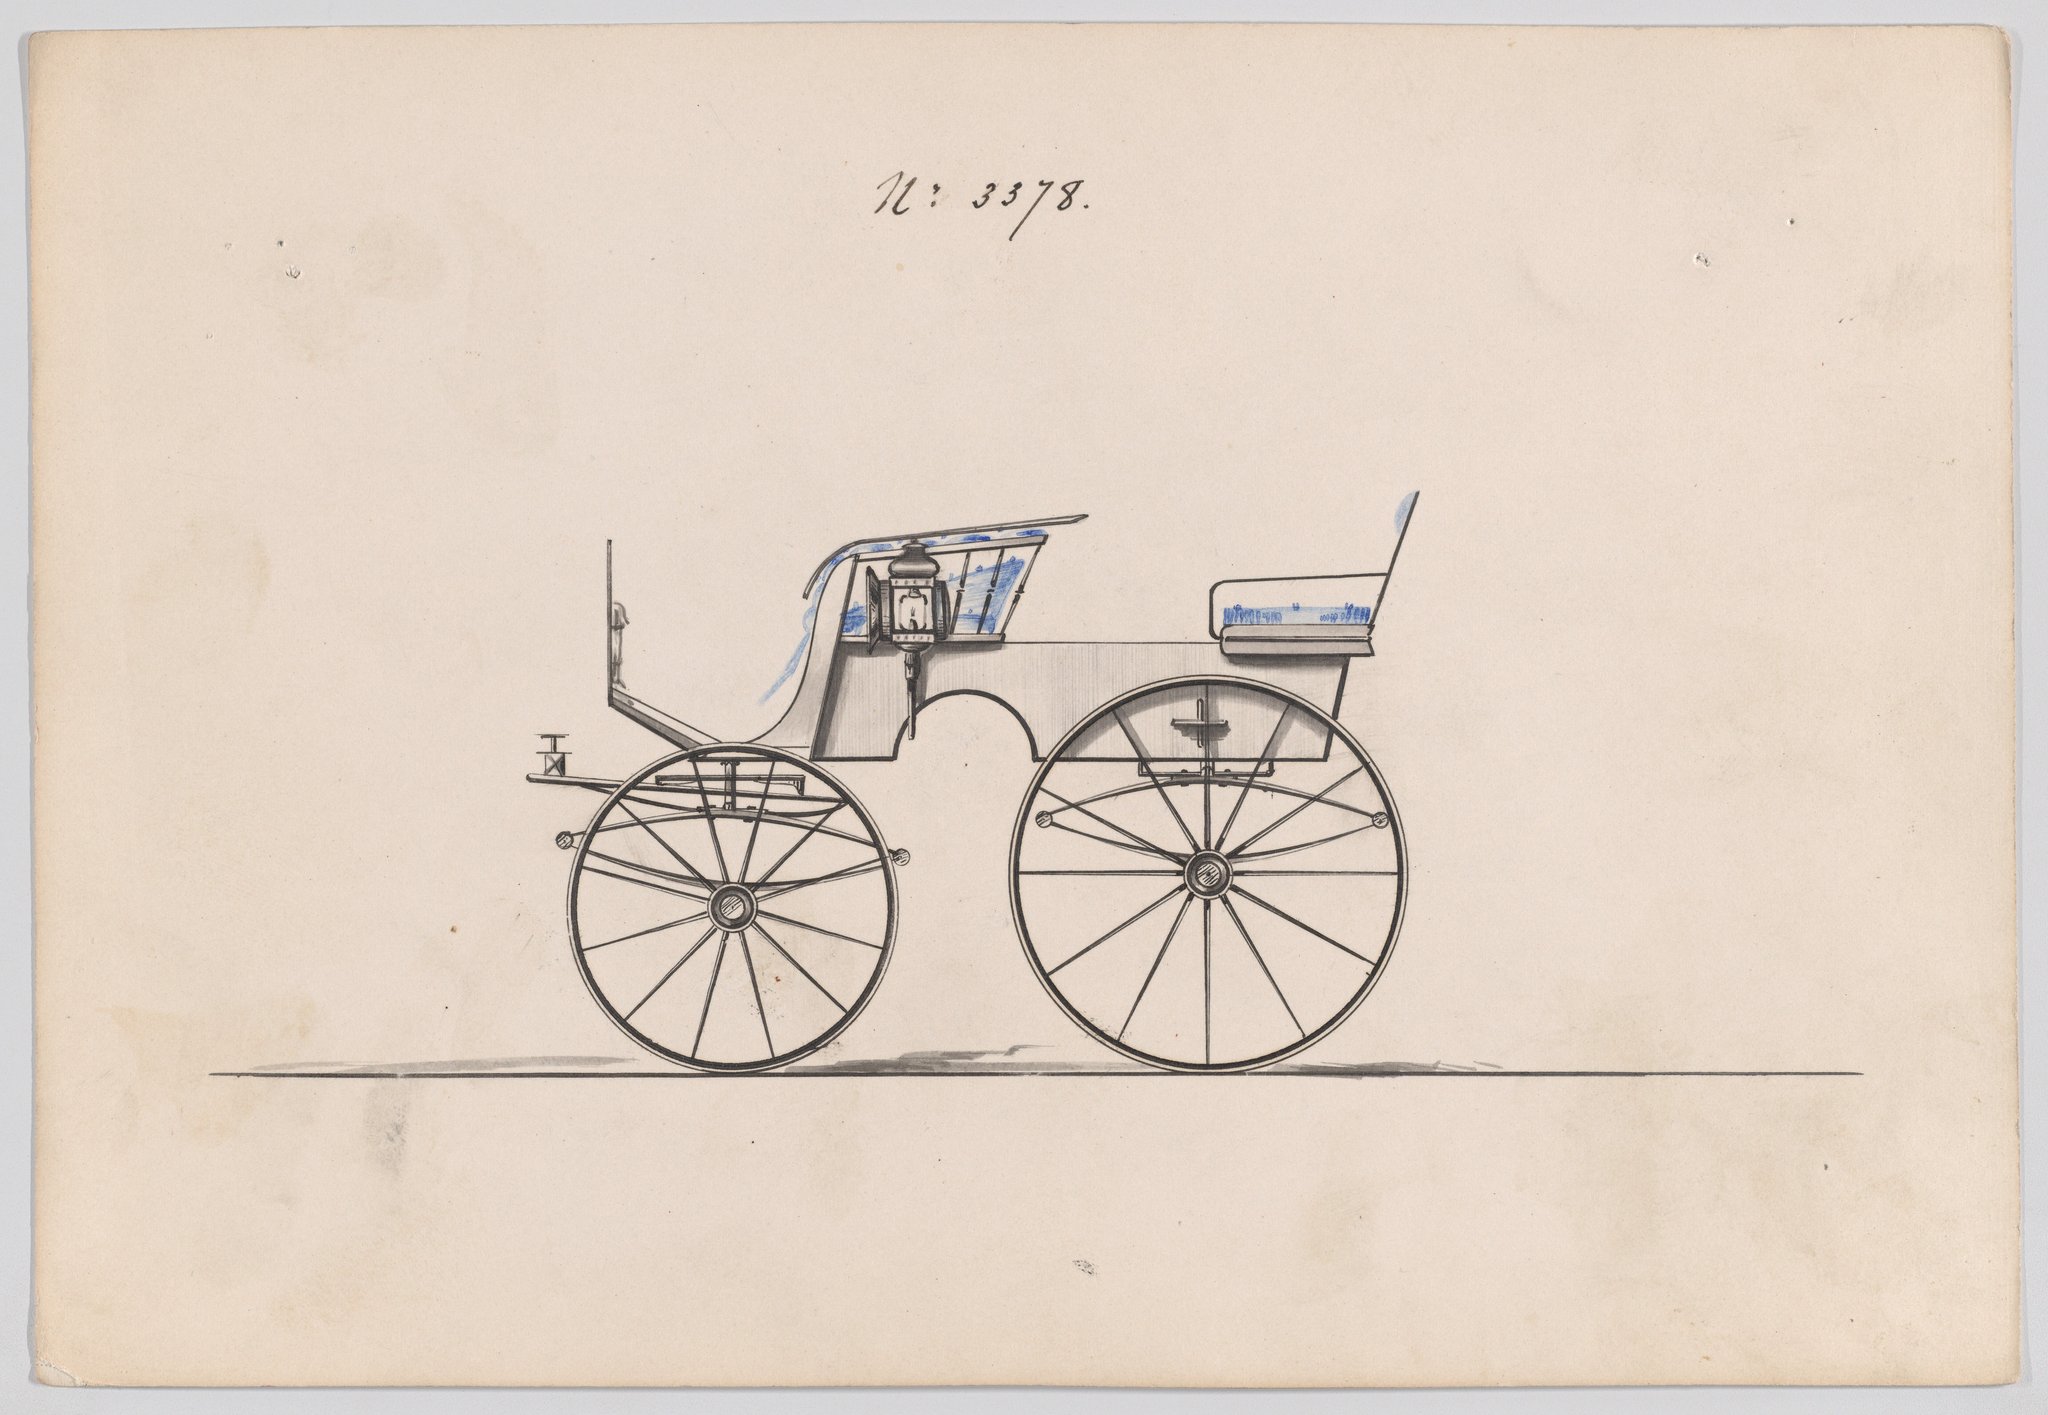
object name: drawing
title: Design for T-Cart, no. 3378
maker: brewster & co.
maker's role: manufacturer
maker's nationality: american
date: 1877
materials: gouache, ink, watercolor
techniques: pen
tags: carriages